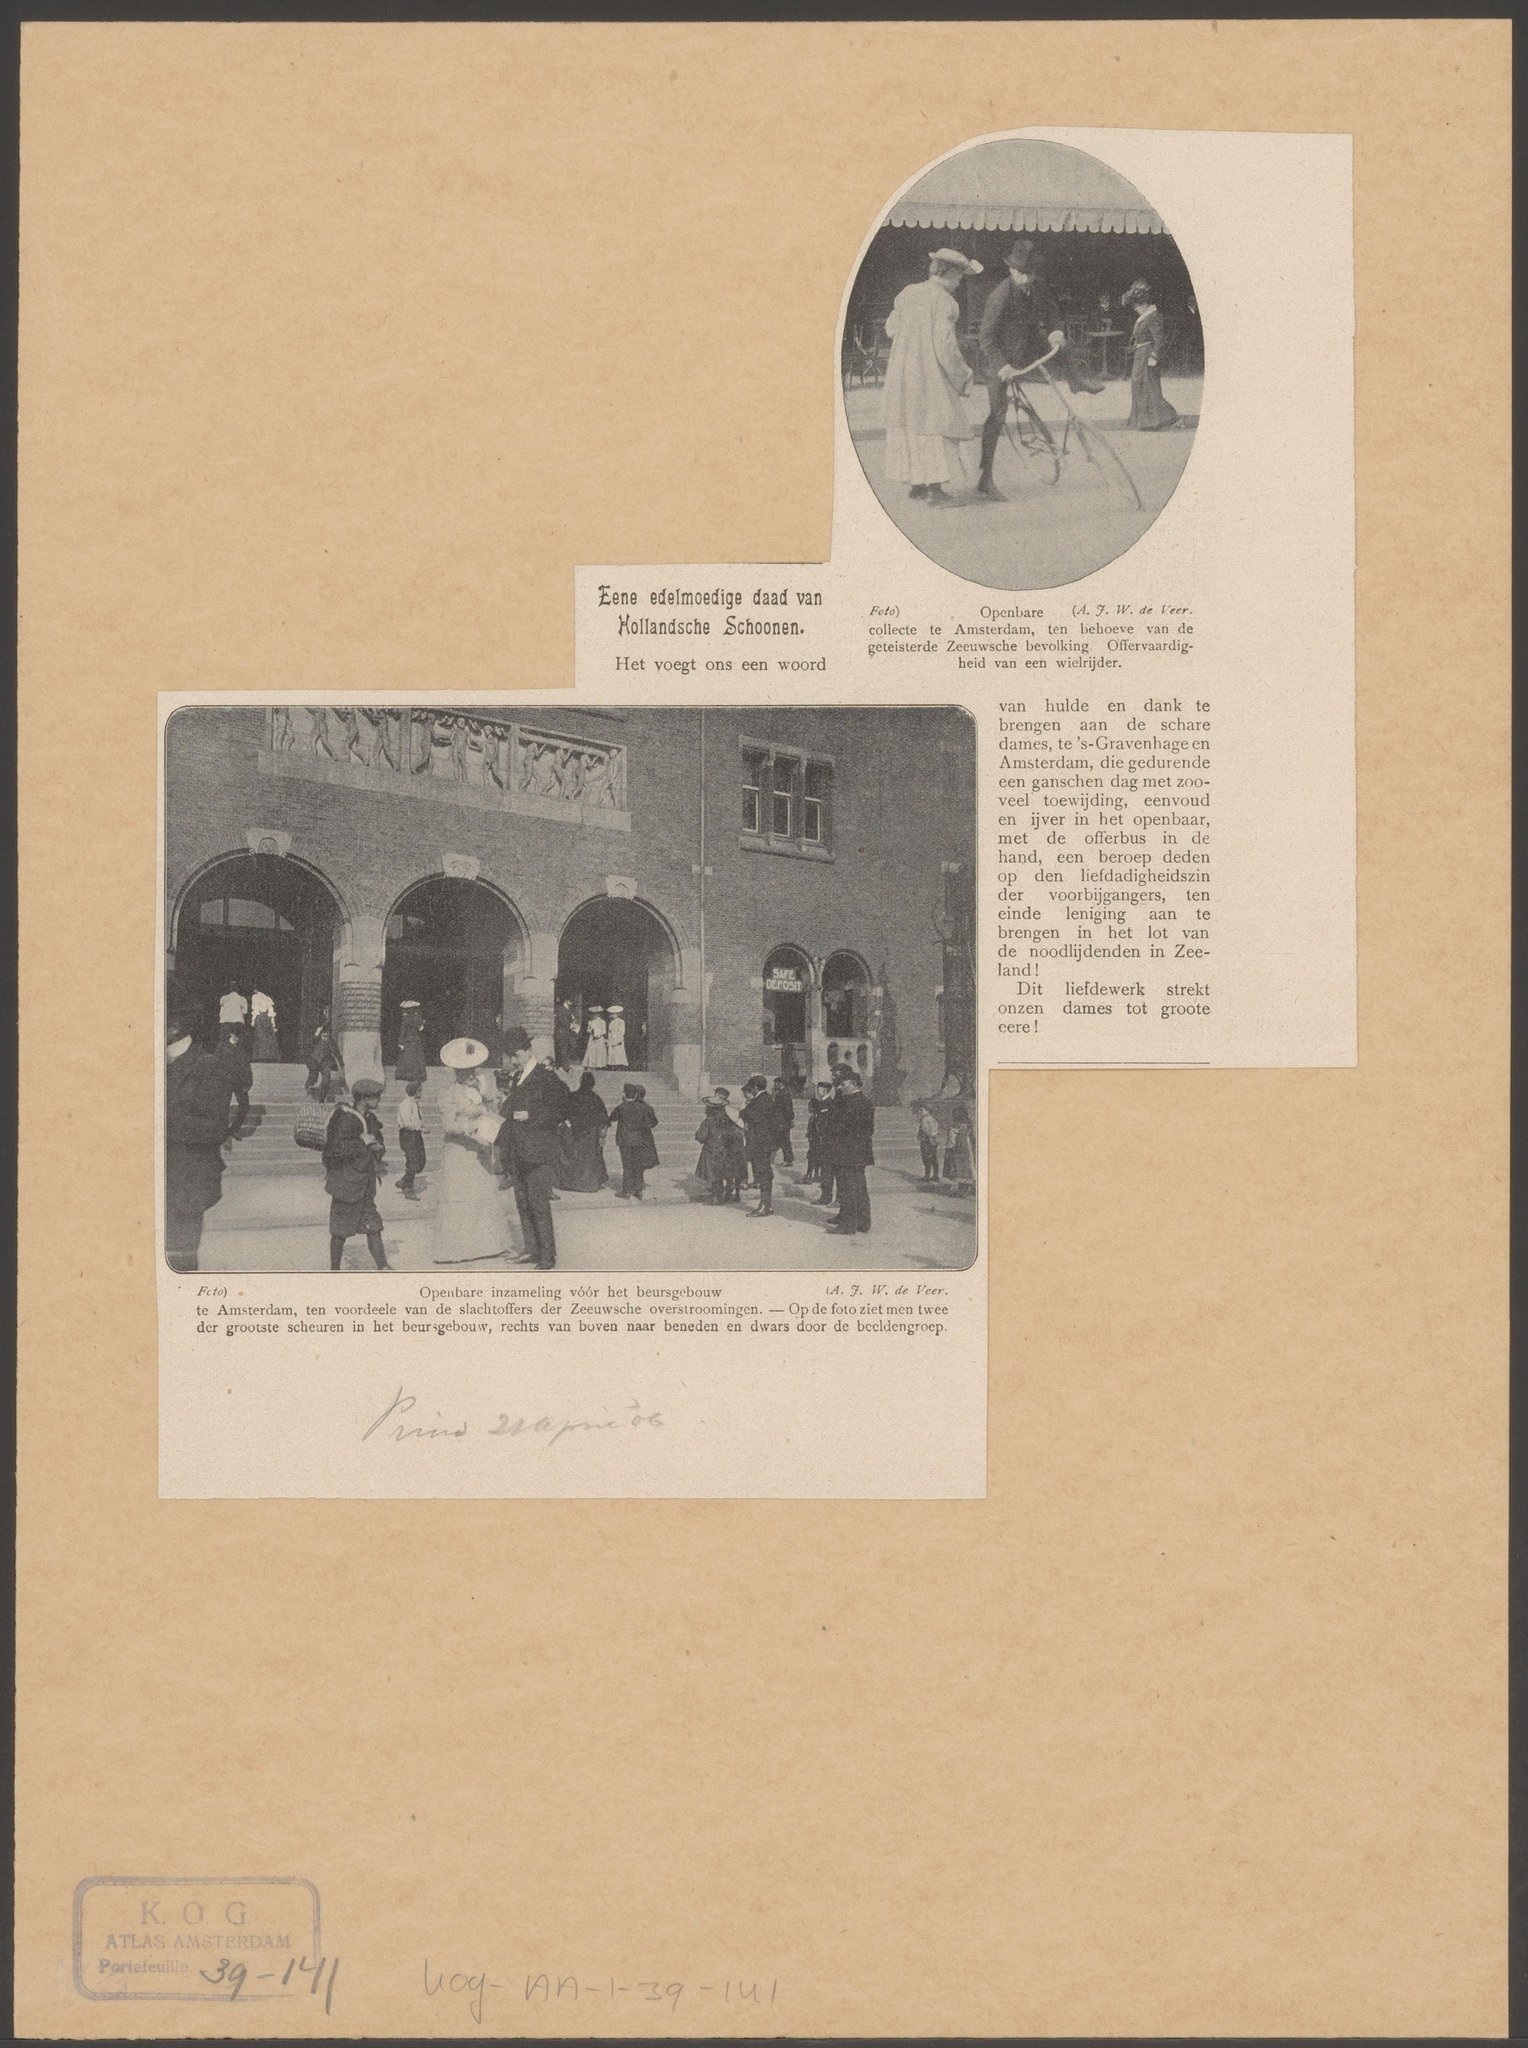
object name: photomechanical print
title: Collecte bij de Beurs van Berlage te Amsterdam ten voordele van de slachtoffers van de Stormvloed van 1906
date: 1906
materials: paper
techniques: letterpress printing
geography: amsterdam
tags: giving alms or other charity, e.g.: handing out food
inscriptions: collector's mark: Lugt 1641b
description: Onderwerpsrubriek binnen de Atlas Amsterdam: Armwezen en liefdadige instellingen: IV. Prenten betrekking hebbende op Philantropie.